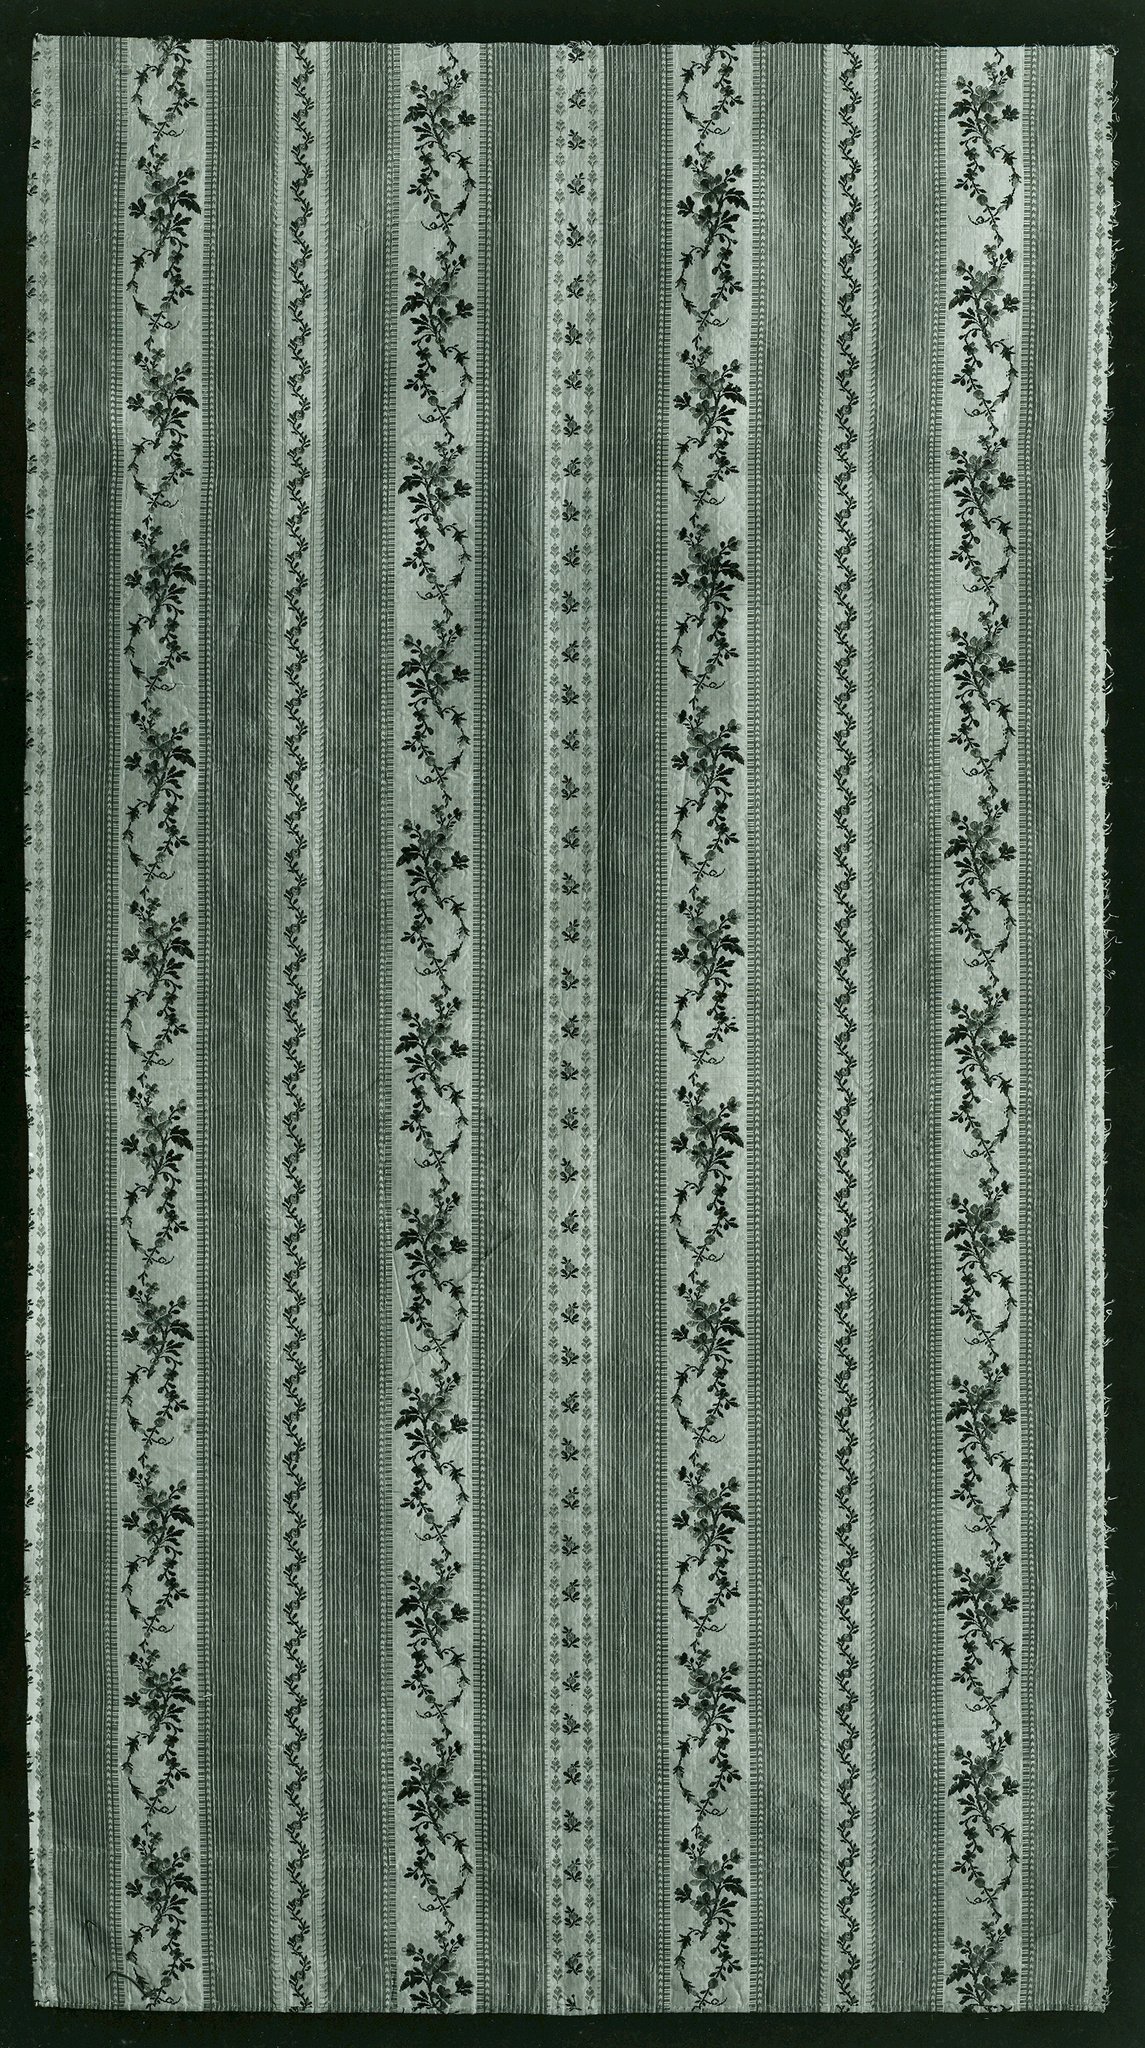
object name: textile panel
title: Panel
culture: spanish or valencian or talavera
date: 1767-1800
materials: cotton, silk